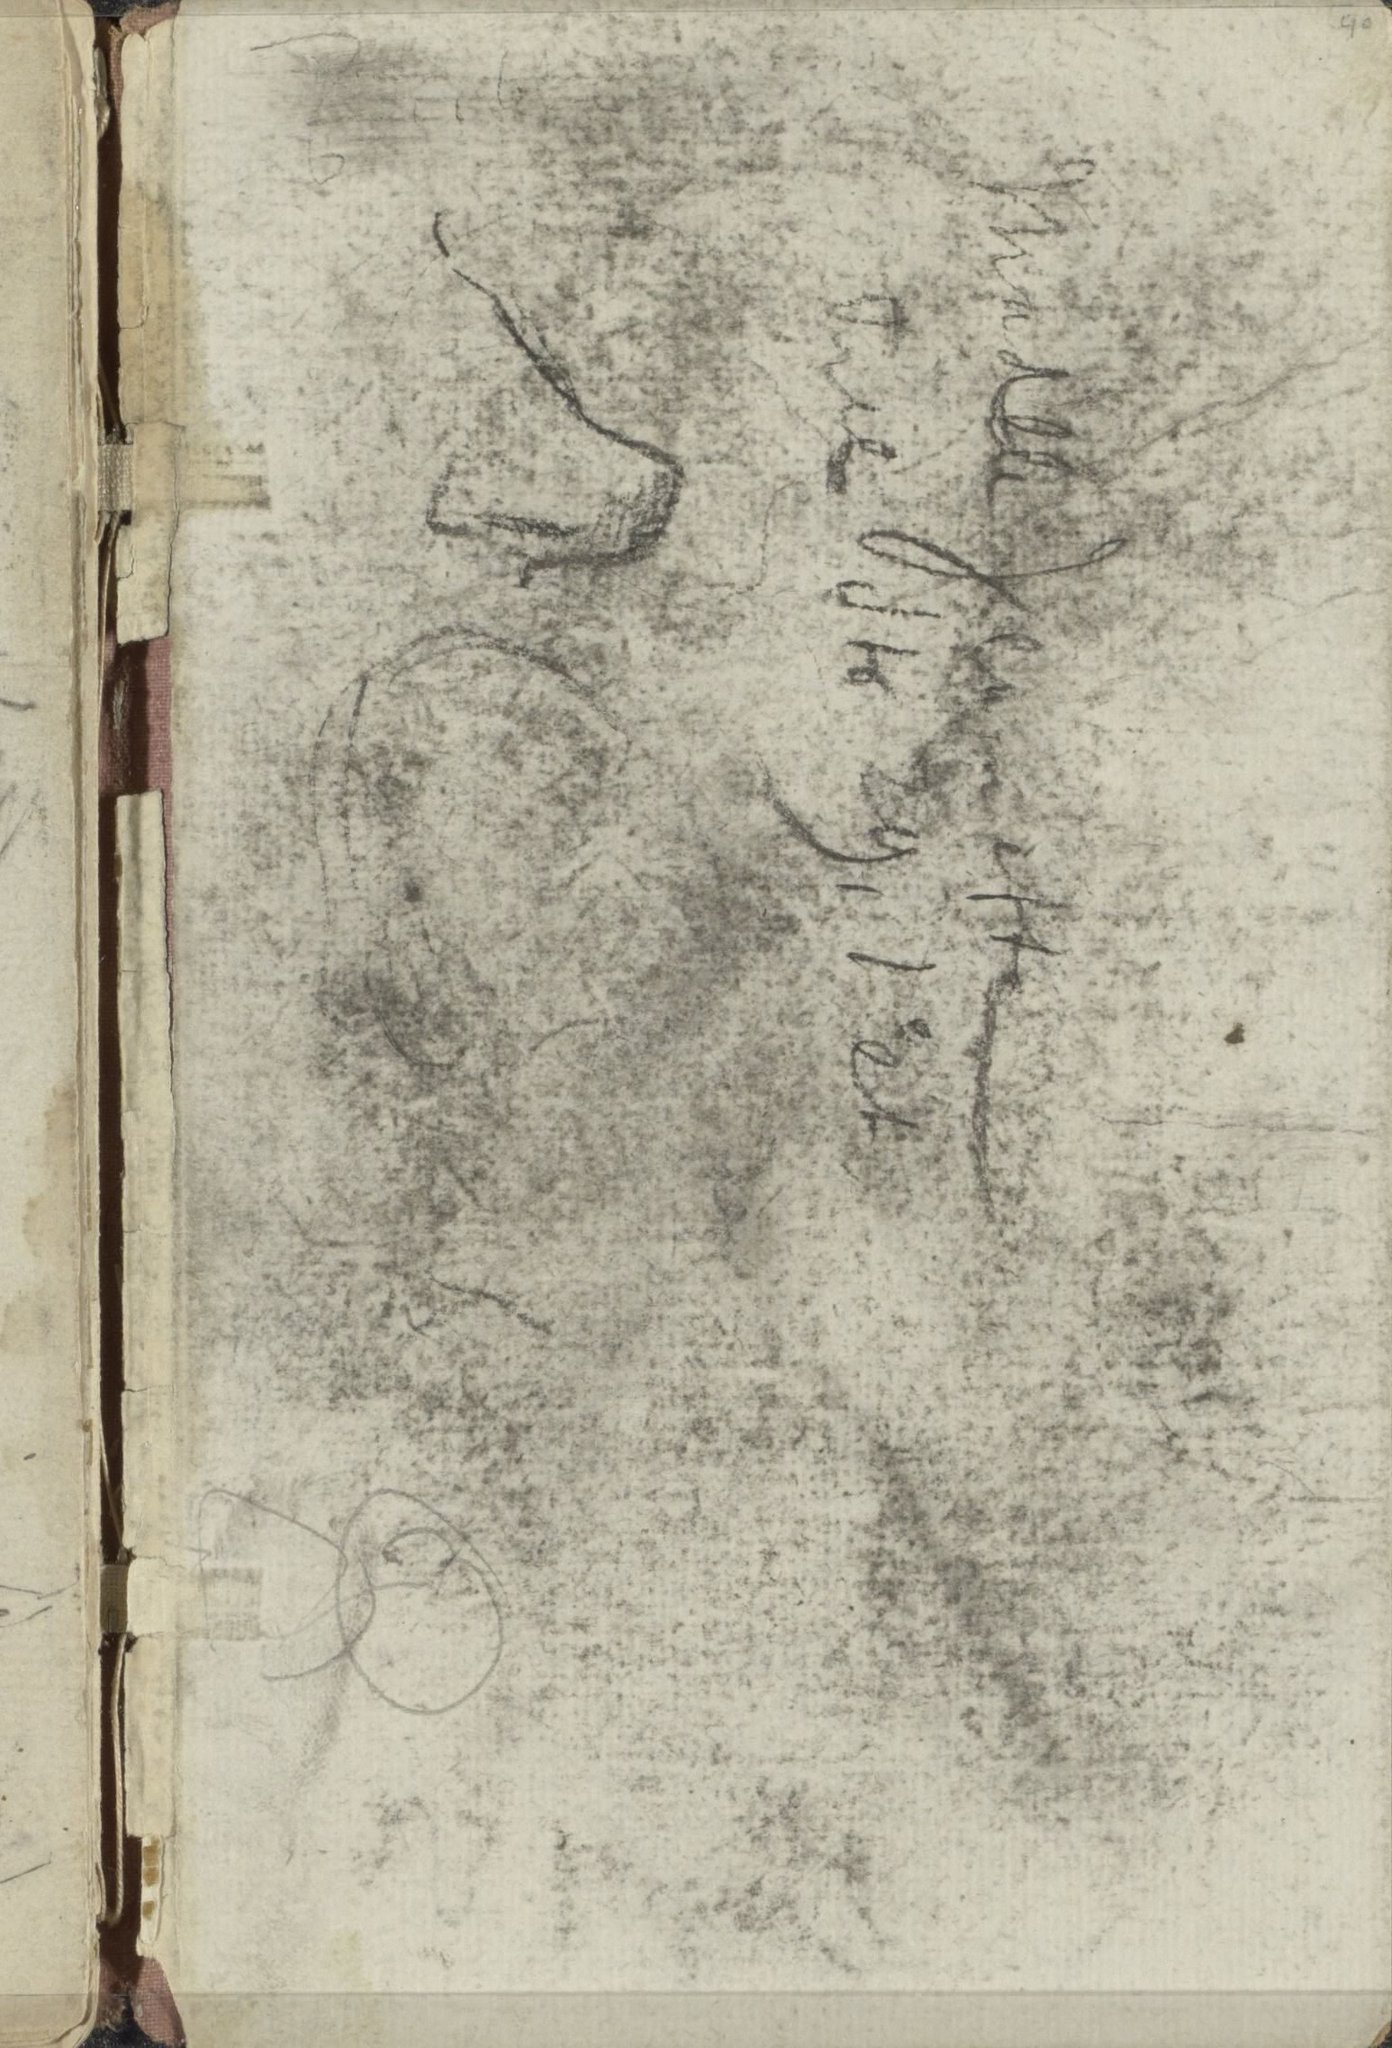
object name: sketchbook leaf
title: Studieblad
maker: george hendrik breitner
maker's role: draughtsman, painter, print maker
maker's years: 1857-1923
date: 1880-1882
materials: chalk, paper, pencil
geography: the hague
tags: animals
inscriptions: annotation: ‘Madlle Jeanette/ Trie[?] str 29, 1e et.’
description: Onder andere een dierenkop. Pagina 40, achterste schutblad, uit een schetsboek met 19 bladen.